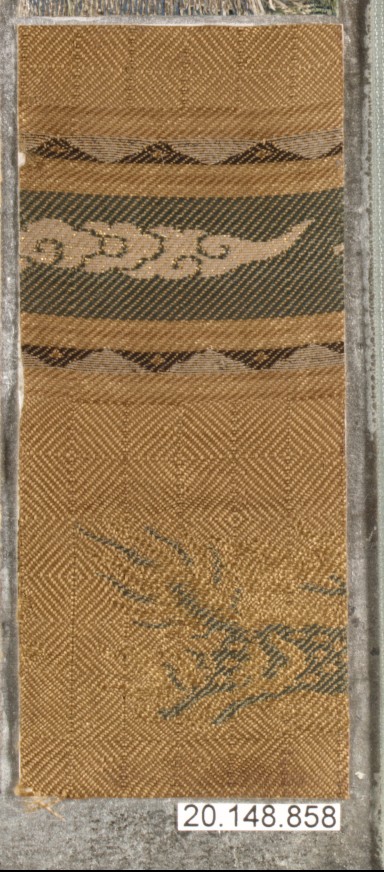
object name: piece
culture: japanese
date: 1701-1800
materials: silk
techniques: compound weave